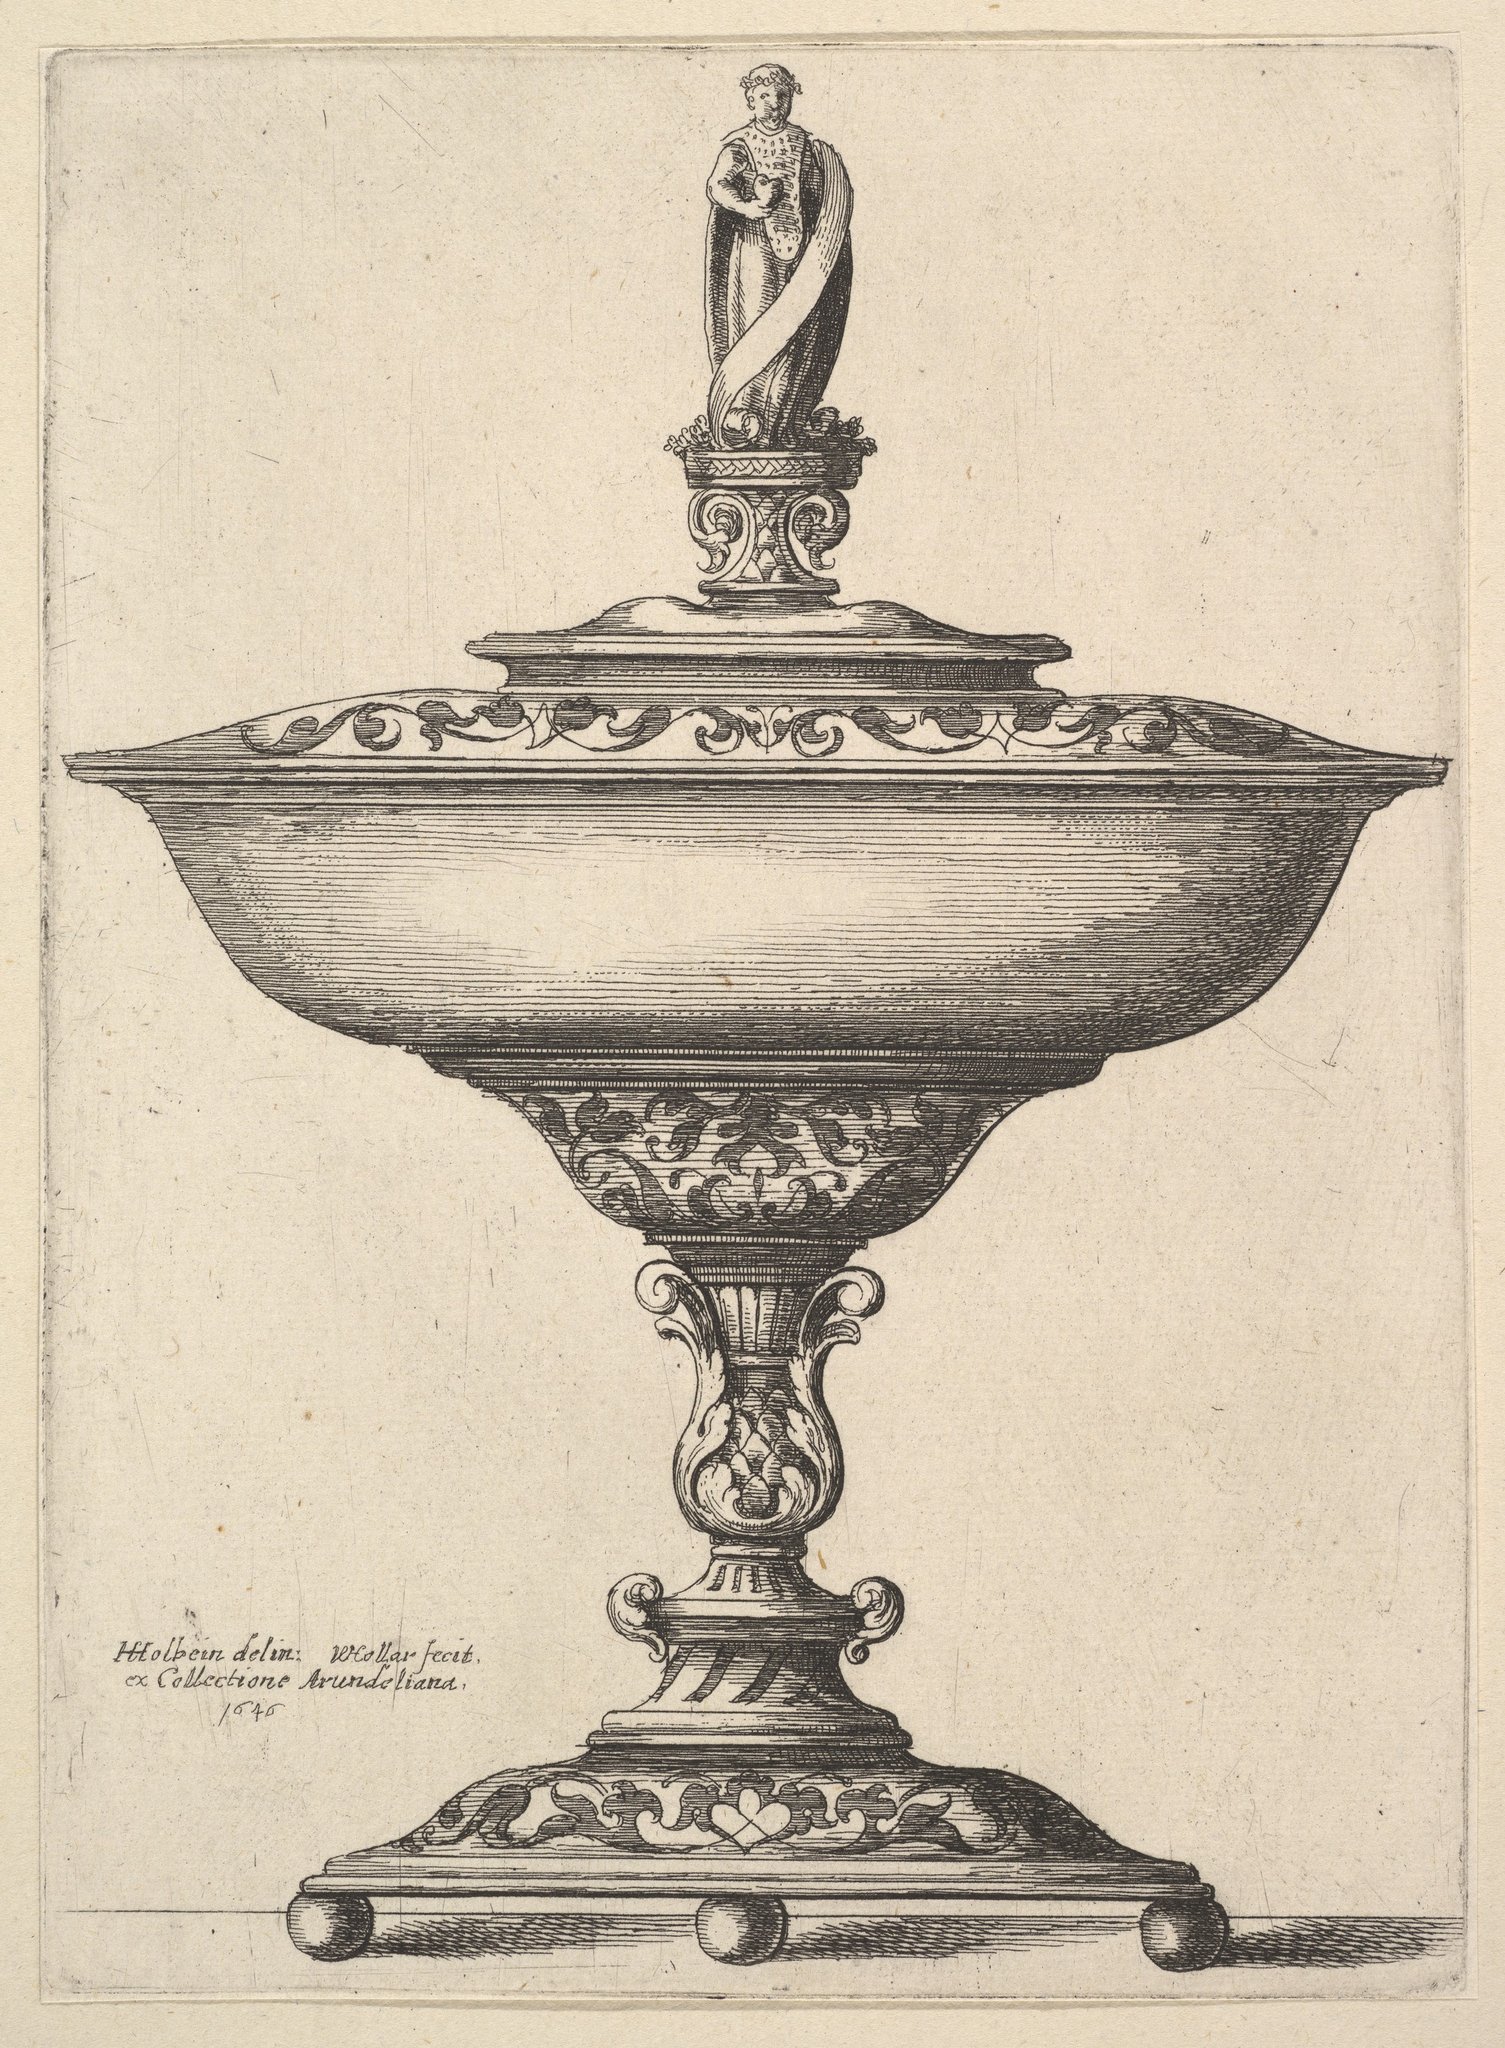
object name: print ornament architecture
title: A wide cup with ball feet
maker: wenceslaus hollar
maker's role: artist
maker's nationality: bohemian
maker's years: 1607-1677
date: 1646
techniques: etching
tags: men,cups